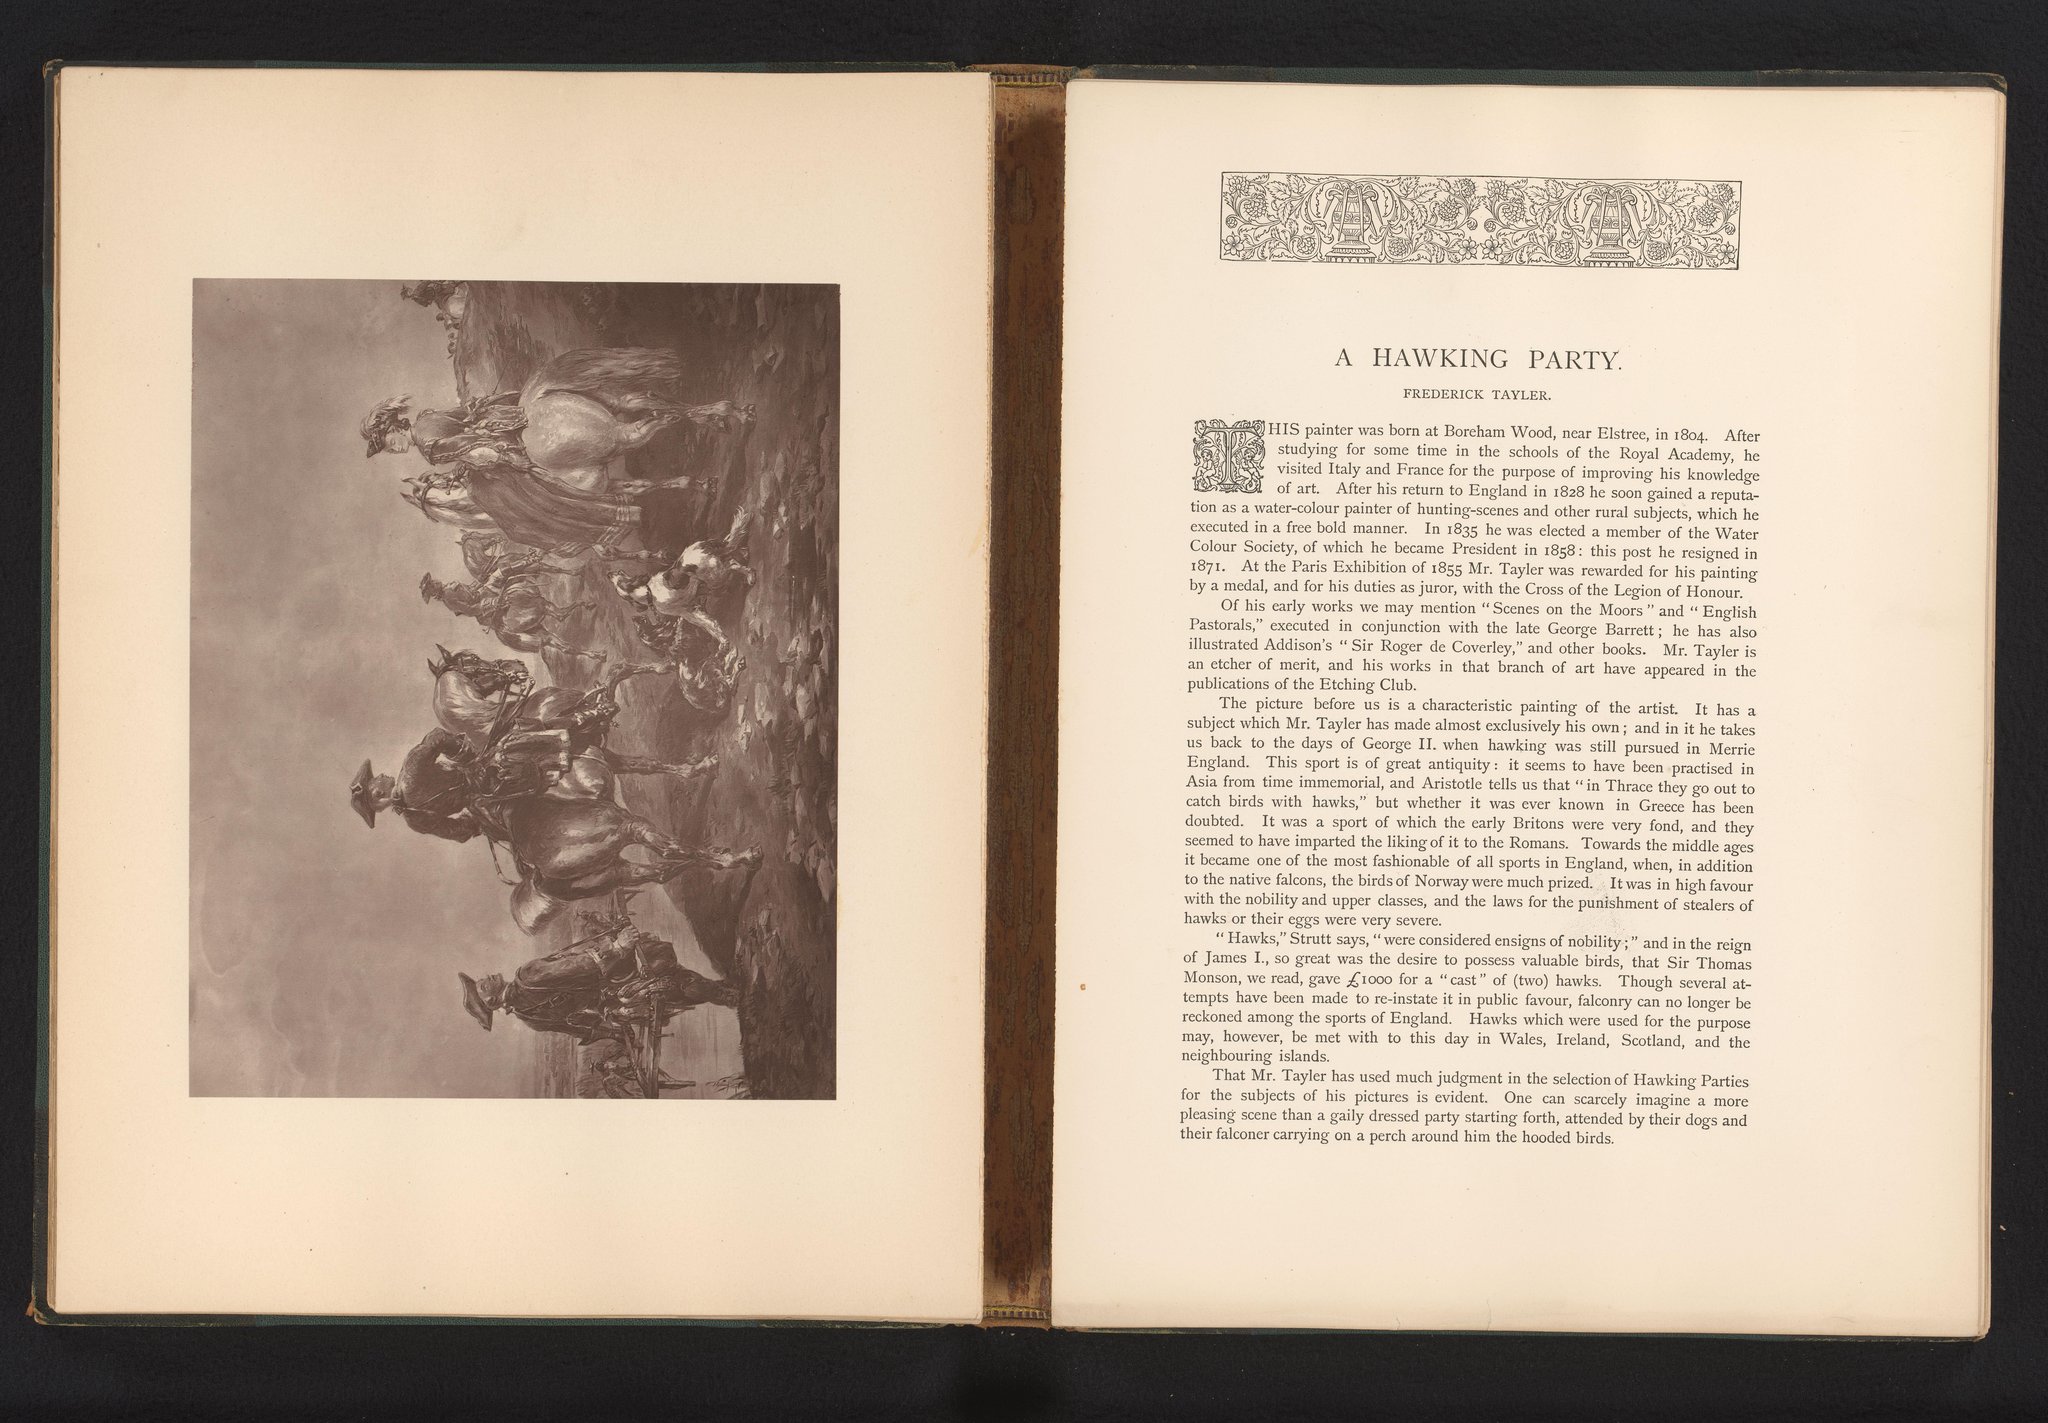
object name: page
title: Reproductie van een schilderij van landschap met een groep valkeniers door John Frederick Tayler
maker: Anonymous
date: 1874-1879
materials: paper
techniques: woodburytype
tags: bird hunting (+ hunting with falcon, hawk; falconry)